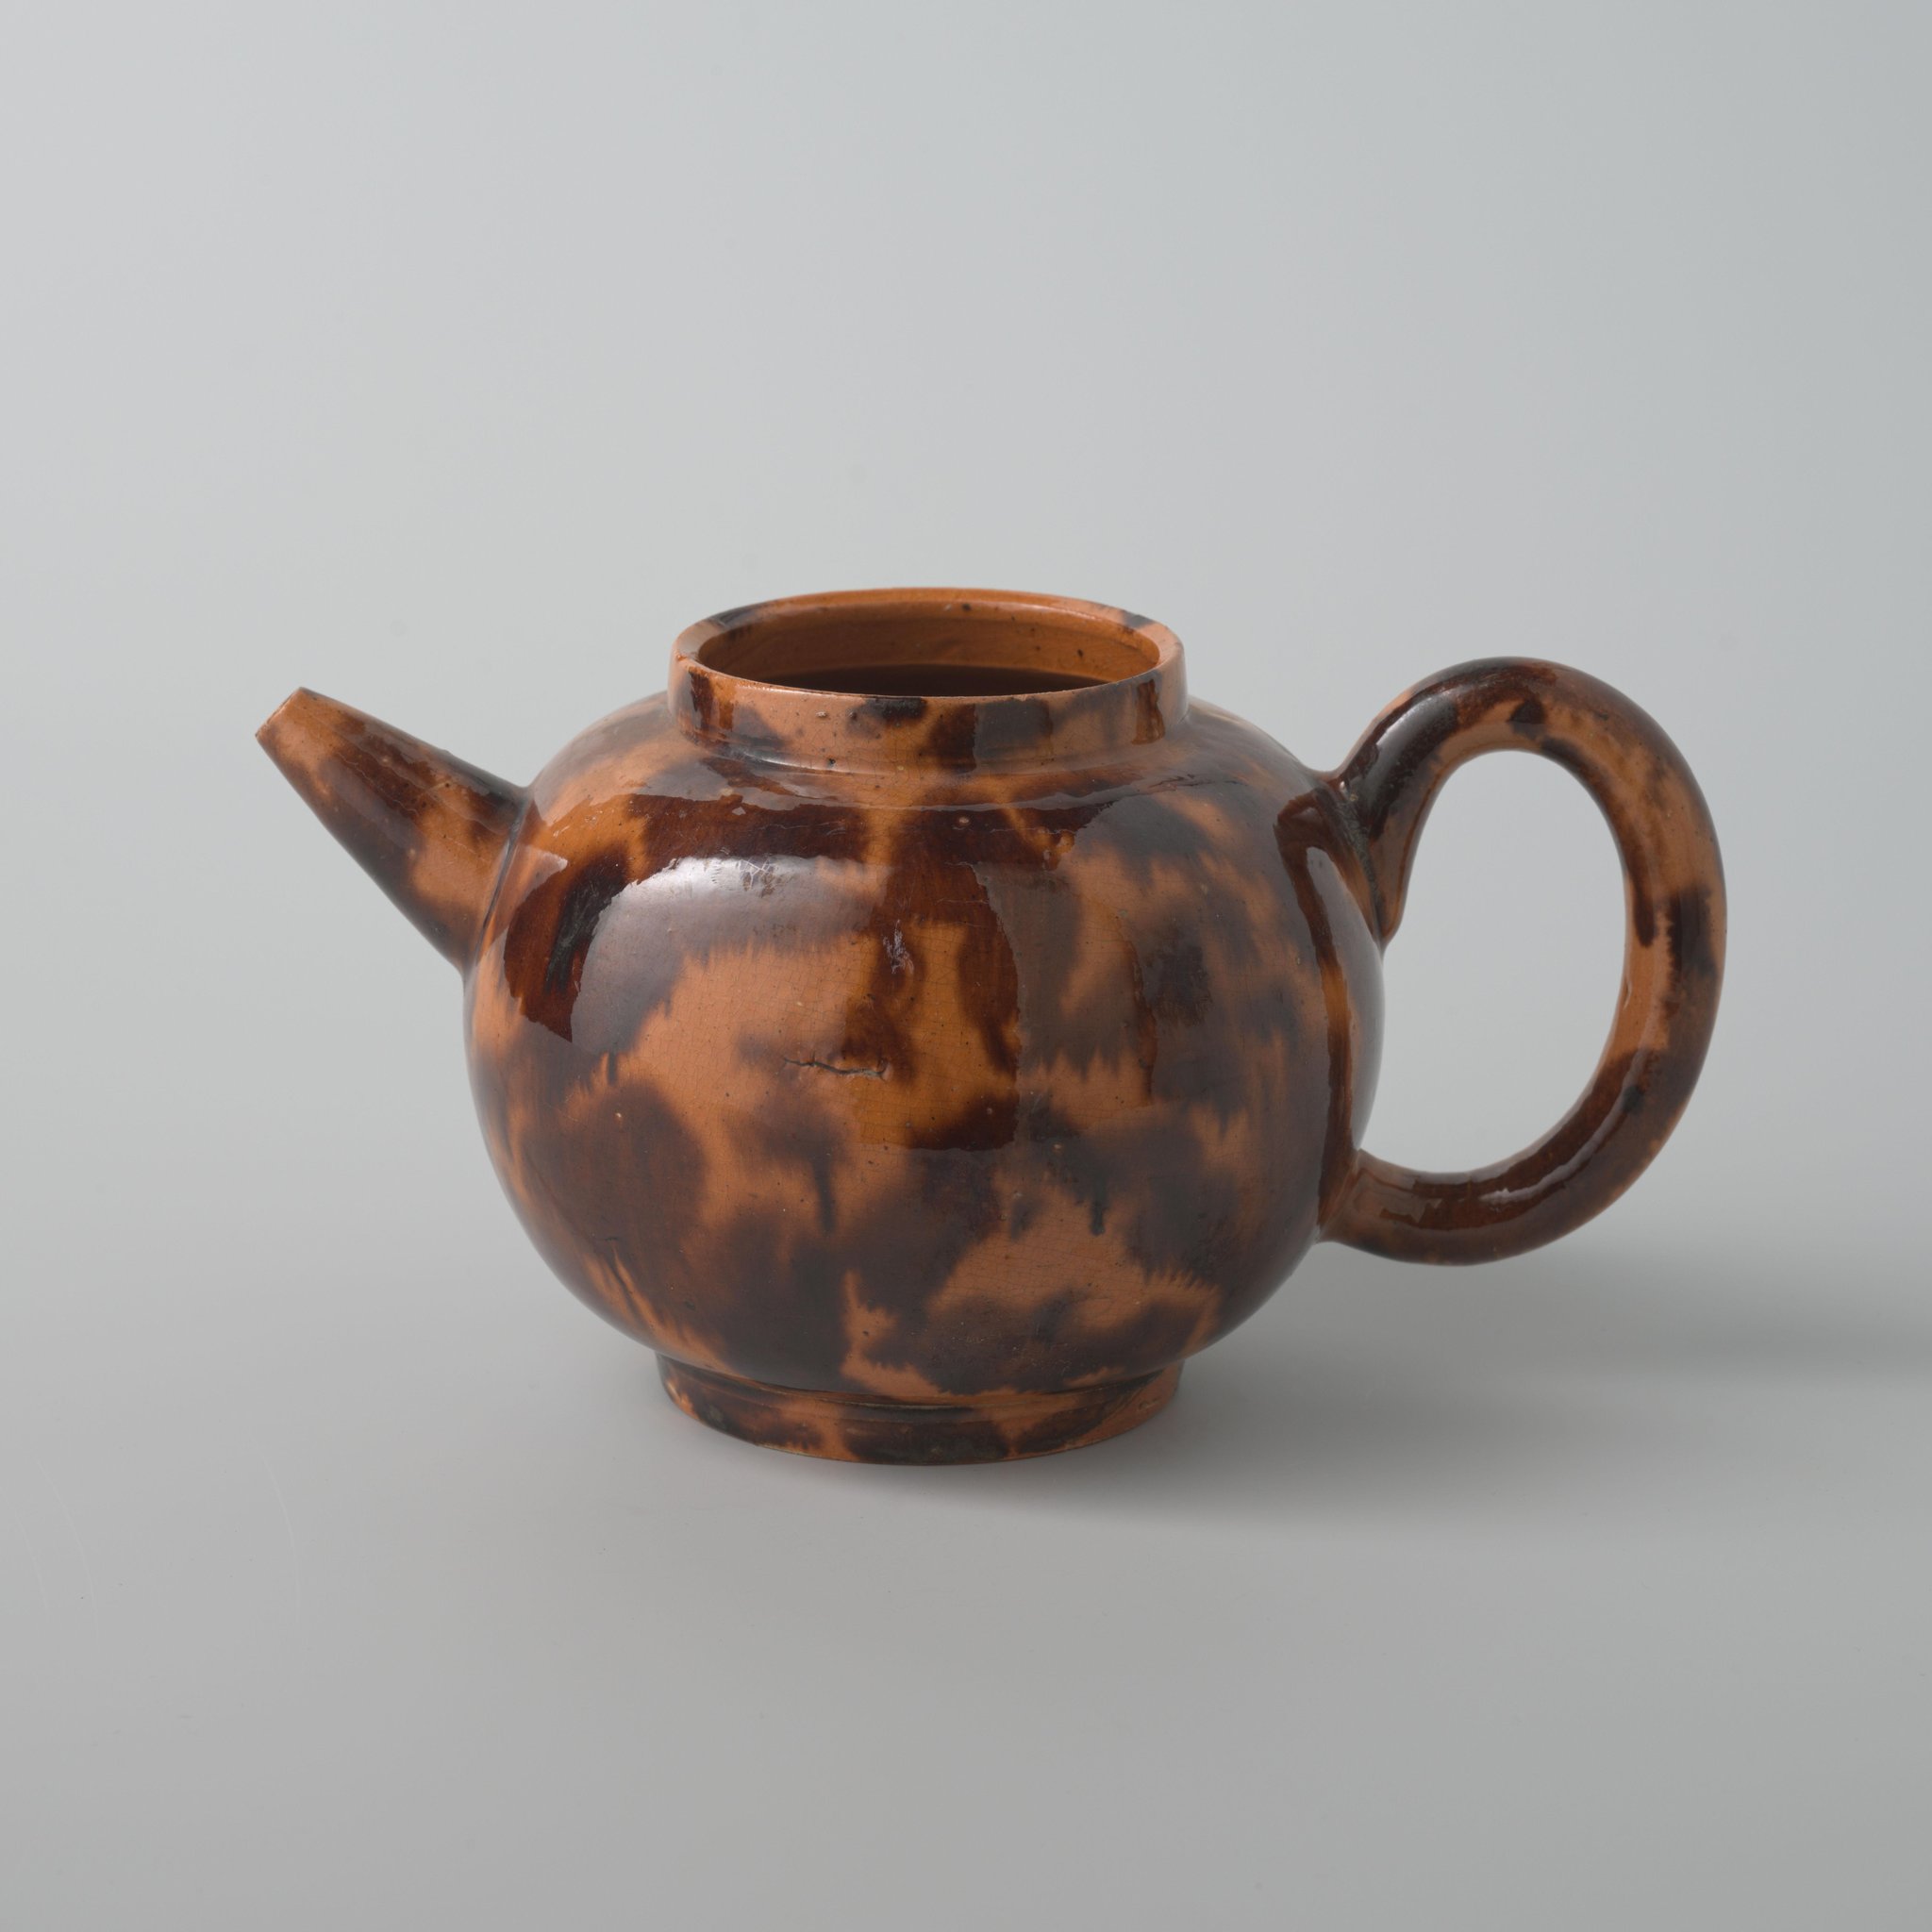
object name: bakafval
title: Theepot van aardewerk met een geel glazuur en bruine vlekken (De Caluwe bakafval)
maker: jacobus de caluwe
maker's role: plateelbakkerij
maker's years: -1730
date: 1700-1725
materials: earthenware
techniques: firing, vitrification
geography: delft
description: Toegeschreven aan Jacobus de Caluwe, omdat dit voorwerp samen met gemerkte stukken (‘Jacobus De Caluwe’ en rennend hert) gevonden is op de plaats waar zich De Caluwes tweede werkplaats bevond. Er is een duidelijke stilistische overeenkomst tussen de gemerkte en niet gemerkte voorwerpen uit deze archeologische vondst.